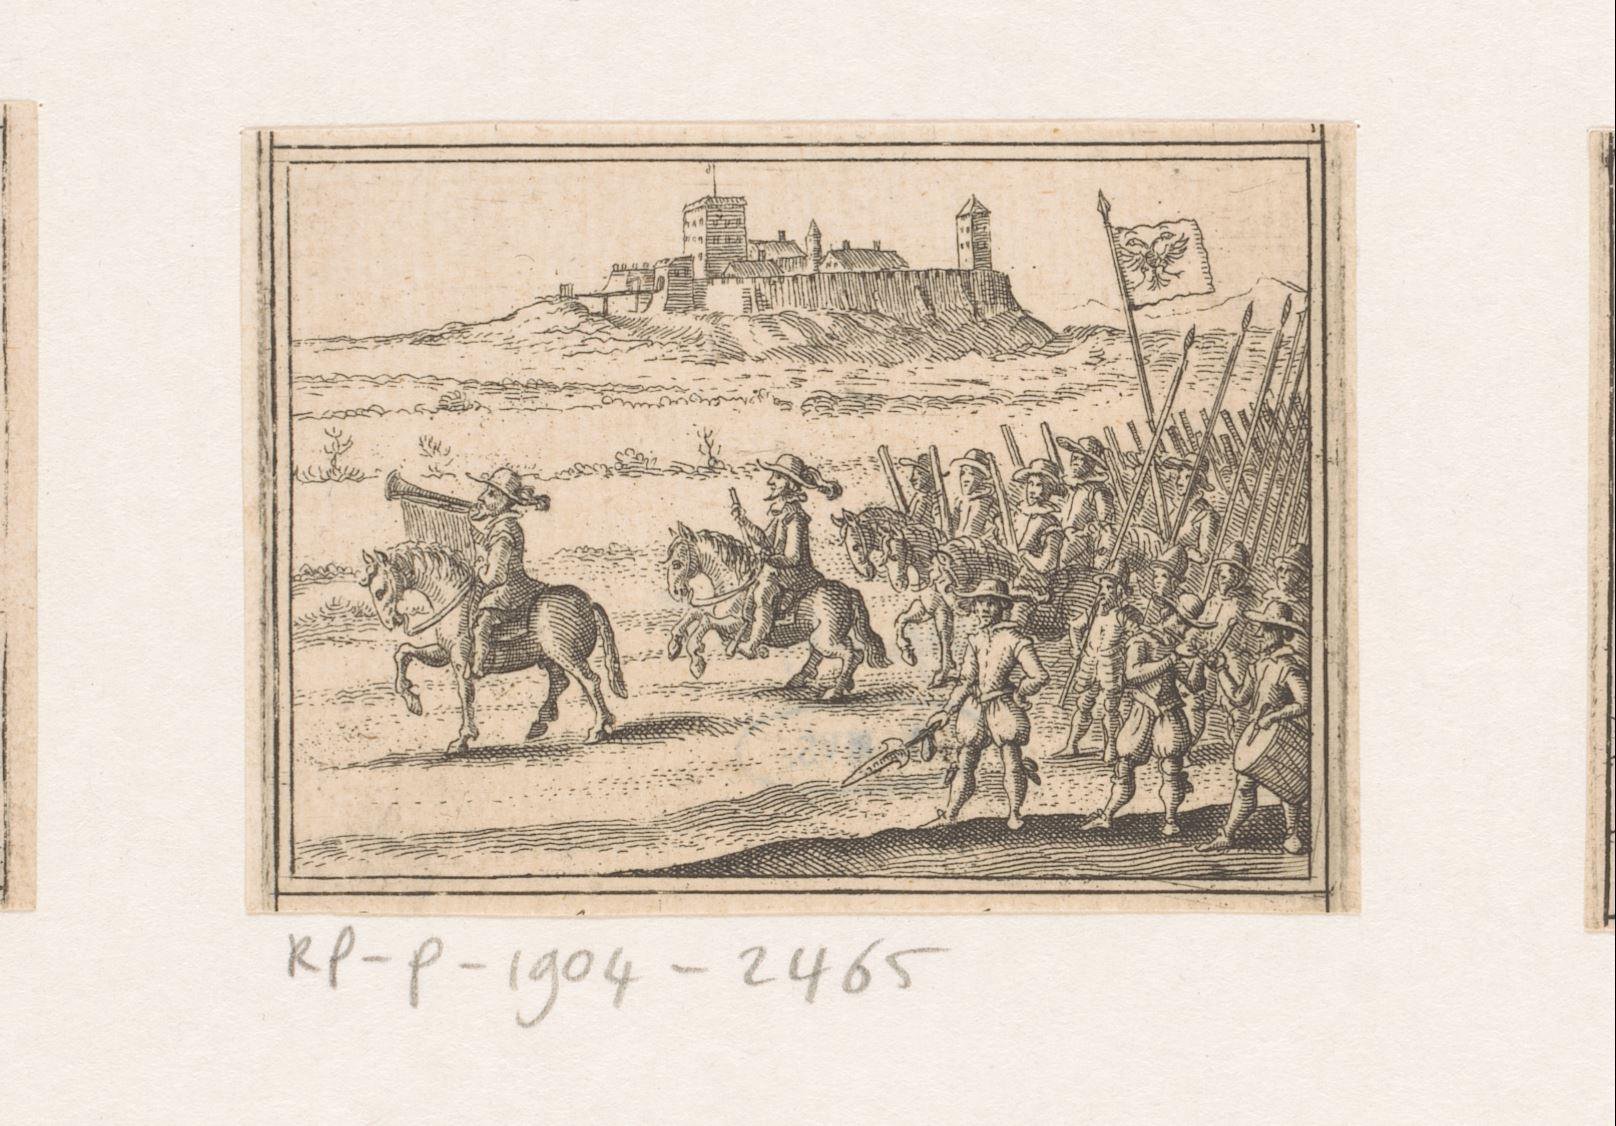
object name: book illustration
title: Keizerlijke cavalerie marcherend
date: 1624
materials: paper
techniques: engraving, etching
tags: riding a horse, ass, or mule; rider, horseman, city-view, and landscape with man-made constructions, marching away (troops), castle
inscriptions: collector's mark: Lugt 2228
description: Prent uit: Sudermann, Daniel. Centuria Similitudinum, Hubert Gleichnussen. Straatsburg, Jacob van der Heyden, 1624. (Hollstein German XXVIA 646).